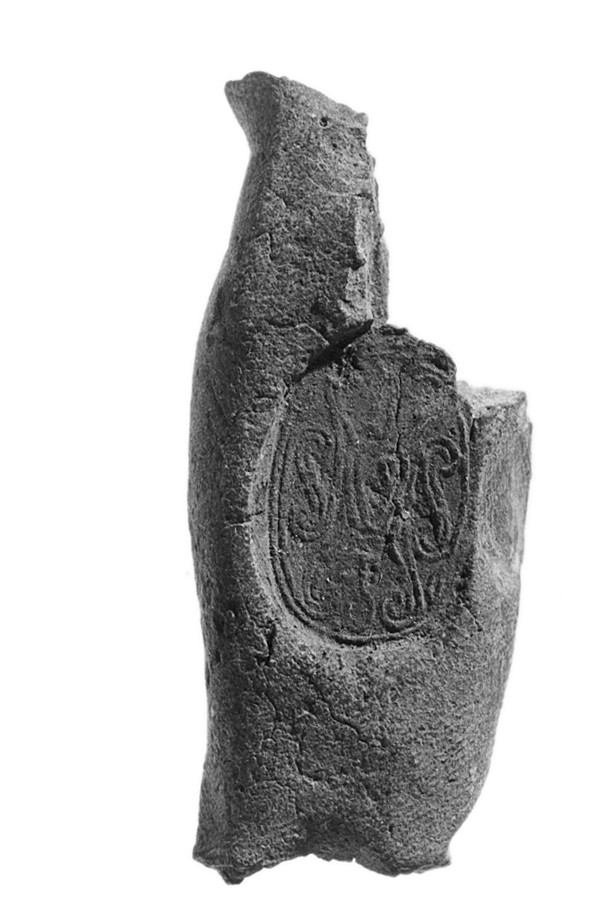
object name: sealing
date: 1981-1640 BCE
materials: clay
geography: egypt